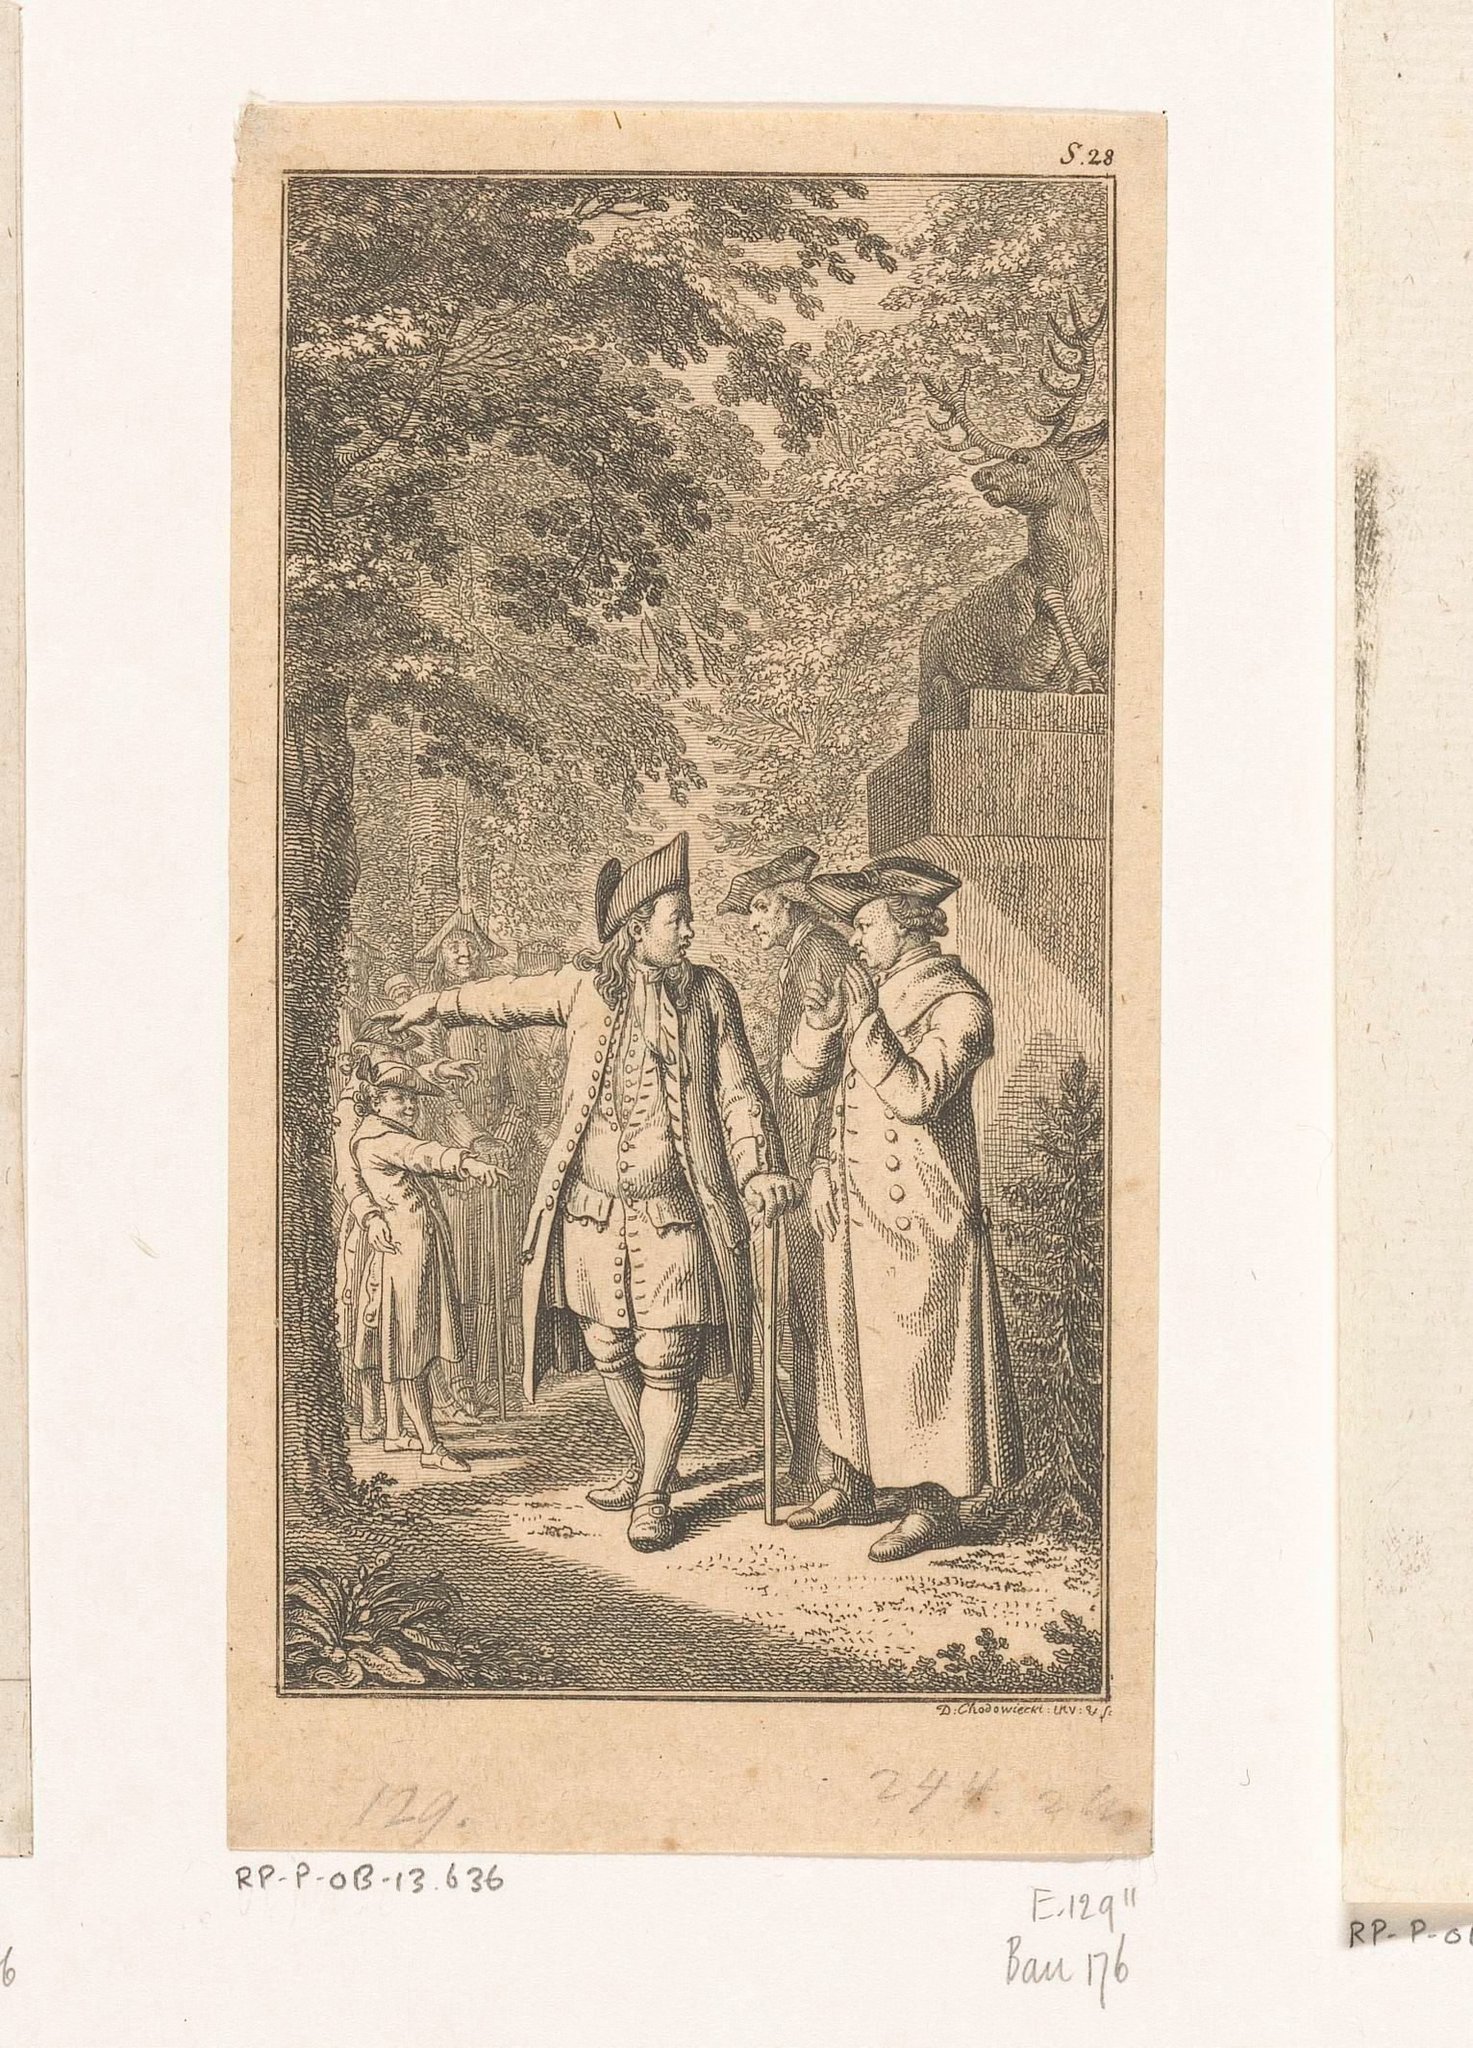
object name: print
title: Sebaldus Nothanker in het park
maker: daniel nikolaus chodowiecki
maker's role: draughtsman, print maker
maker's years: 1726-1801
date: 1775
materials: paper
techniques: etching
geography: berlin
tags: berlin, publisher, friedrich nicolai, literature, public gardens, park, statues, sculptures in garden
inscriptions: collector's mark: Lugt 2228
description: Deze scène behoort tot een serie prenten die het verhaal van Sebaldus Nothanker door Friedrich Nicolai illustreren. Deze prent is ook gebruikt in: [Nicolai Friedrich]. Das Leben und die Meinungen des Herrn Magister Sebaldus Nothanker. Berlijn en Stettin: Friedrich Nicolai, 1775, dl. 2.